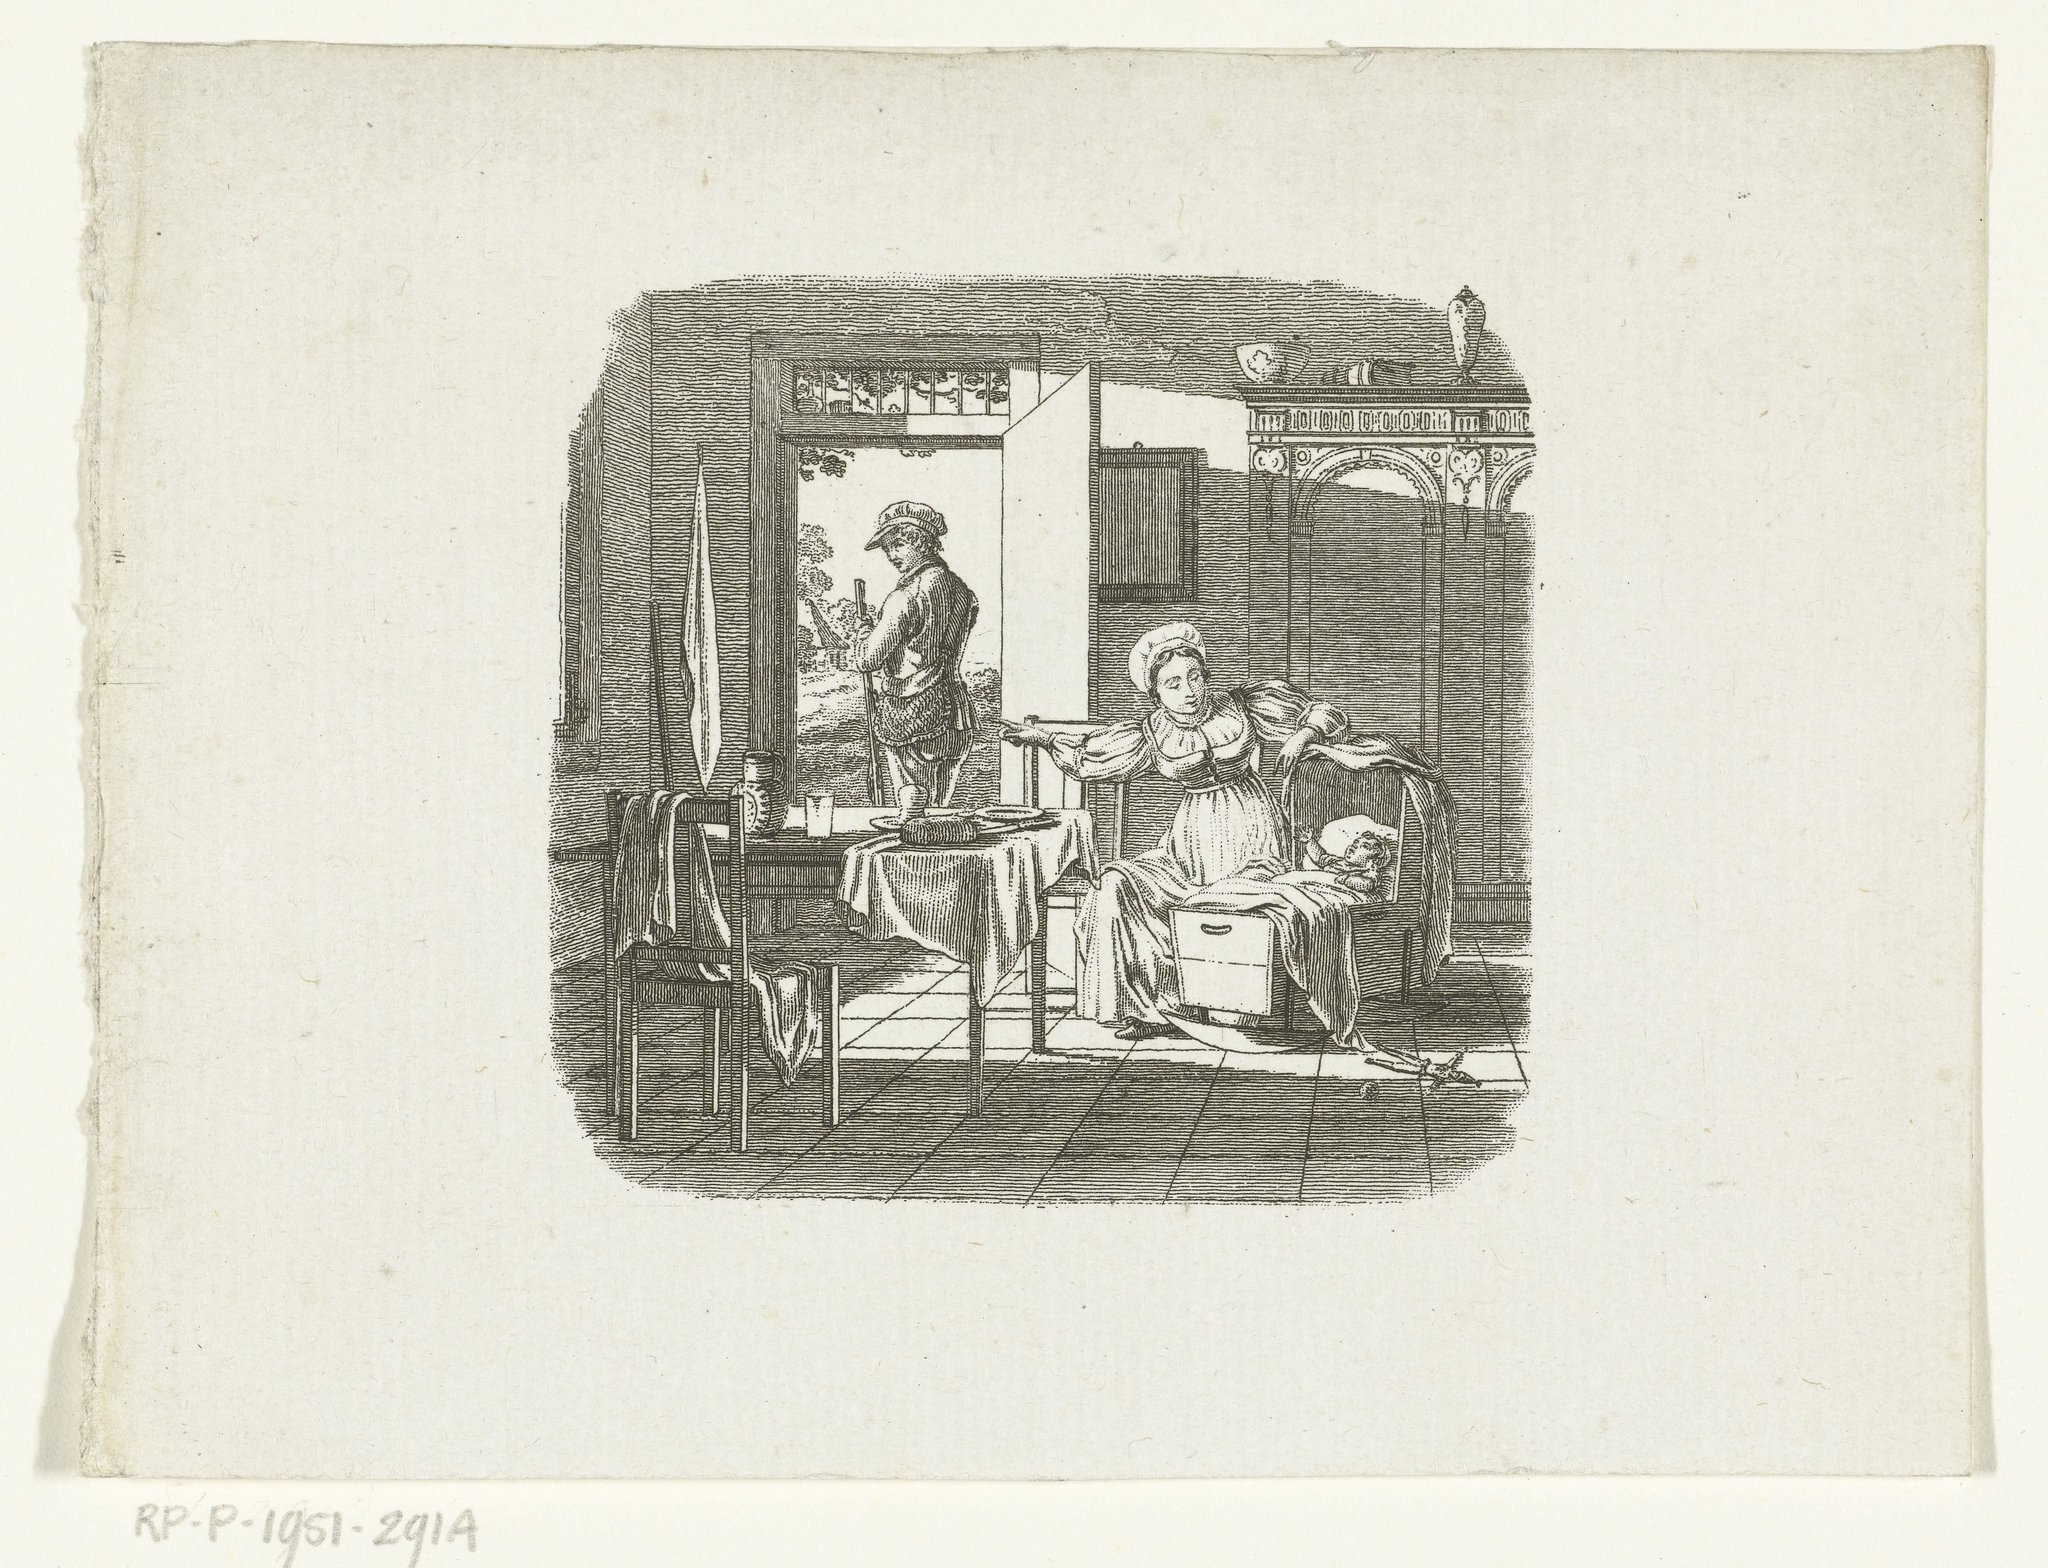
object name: print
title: Moeder bij kind in wieg dat zwaait naar vader die met geweer huis verlaat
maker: johannes christiaan bendorp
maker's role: print maker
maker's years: 1766-1849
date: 1776-1849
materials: paper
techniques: etching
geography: netherlands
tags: family life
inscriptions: collector's mark: Lugt 2228